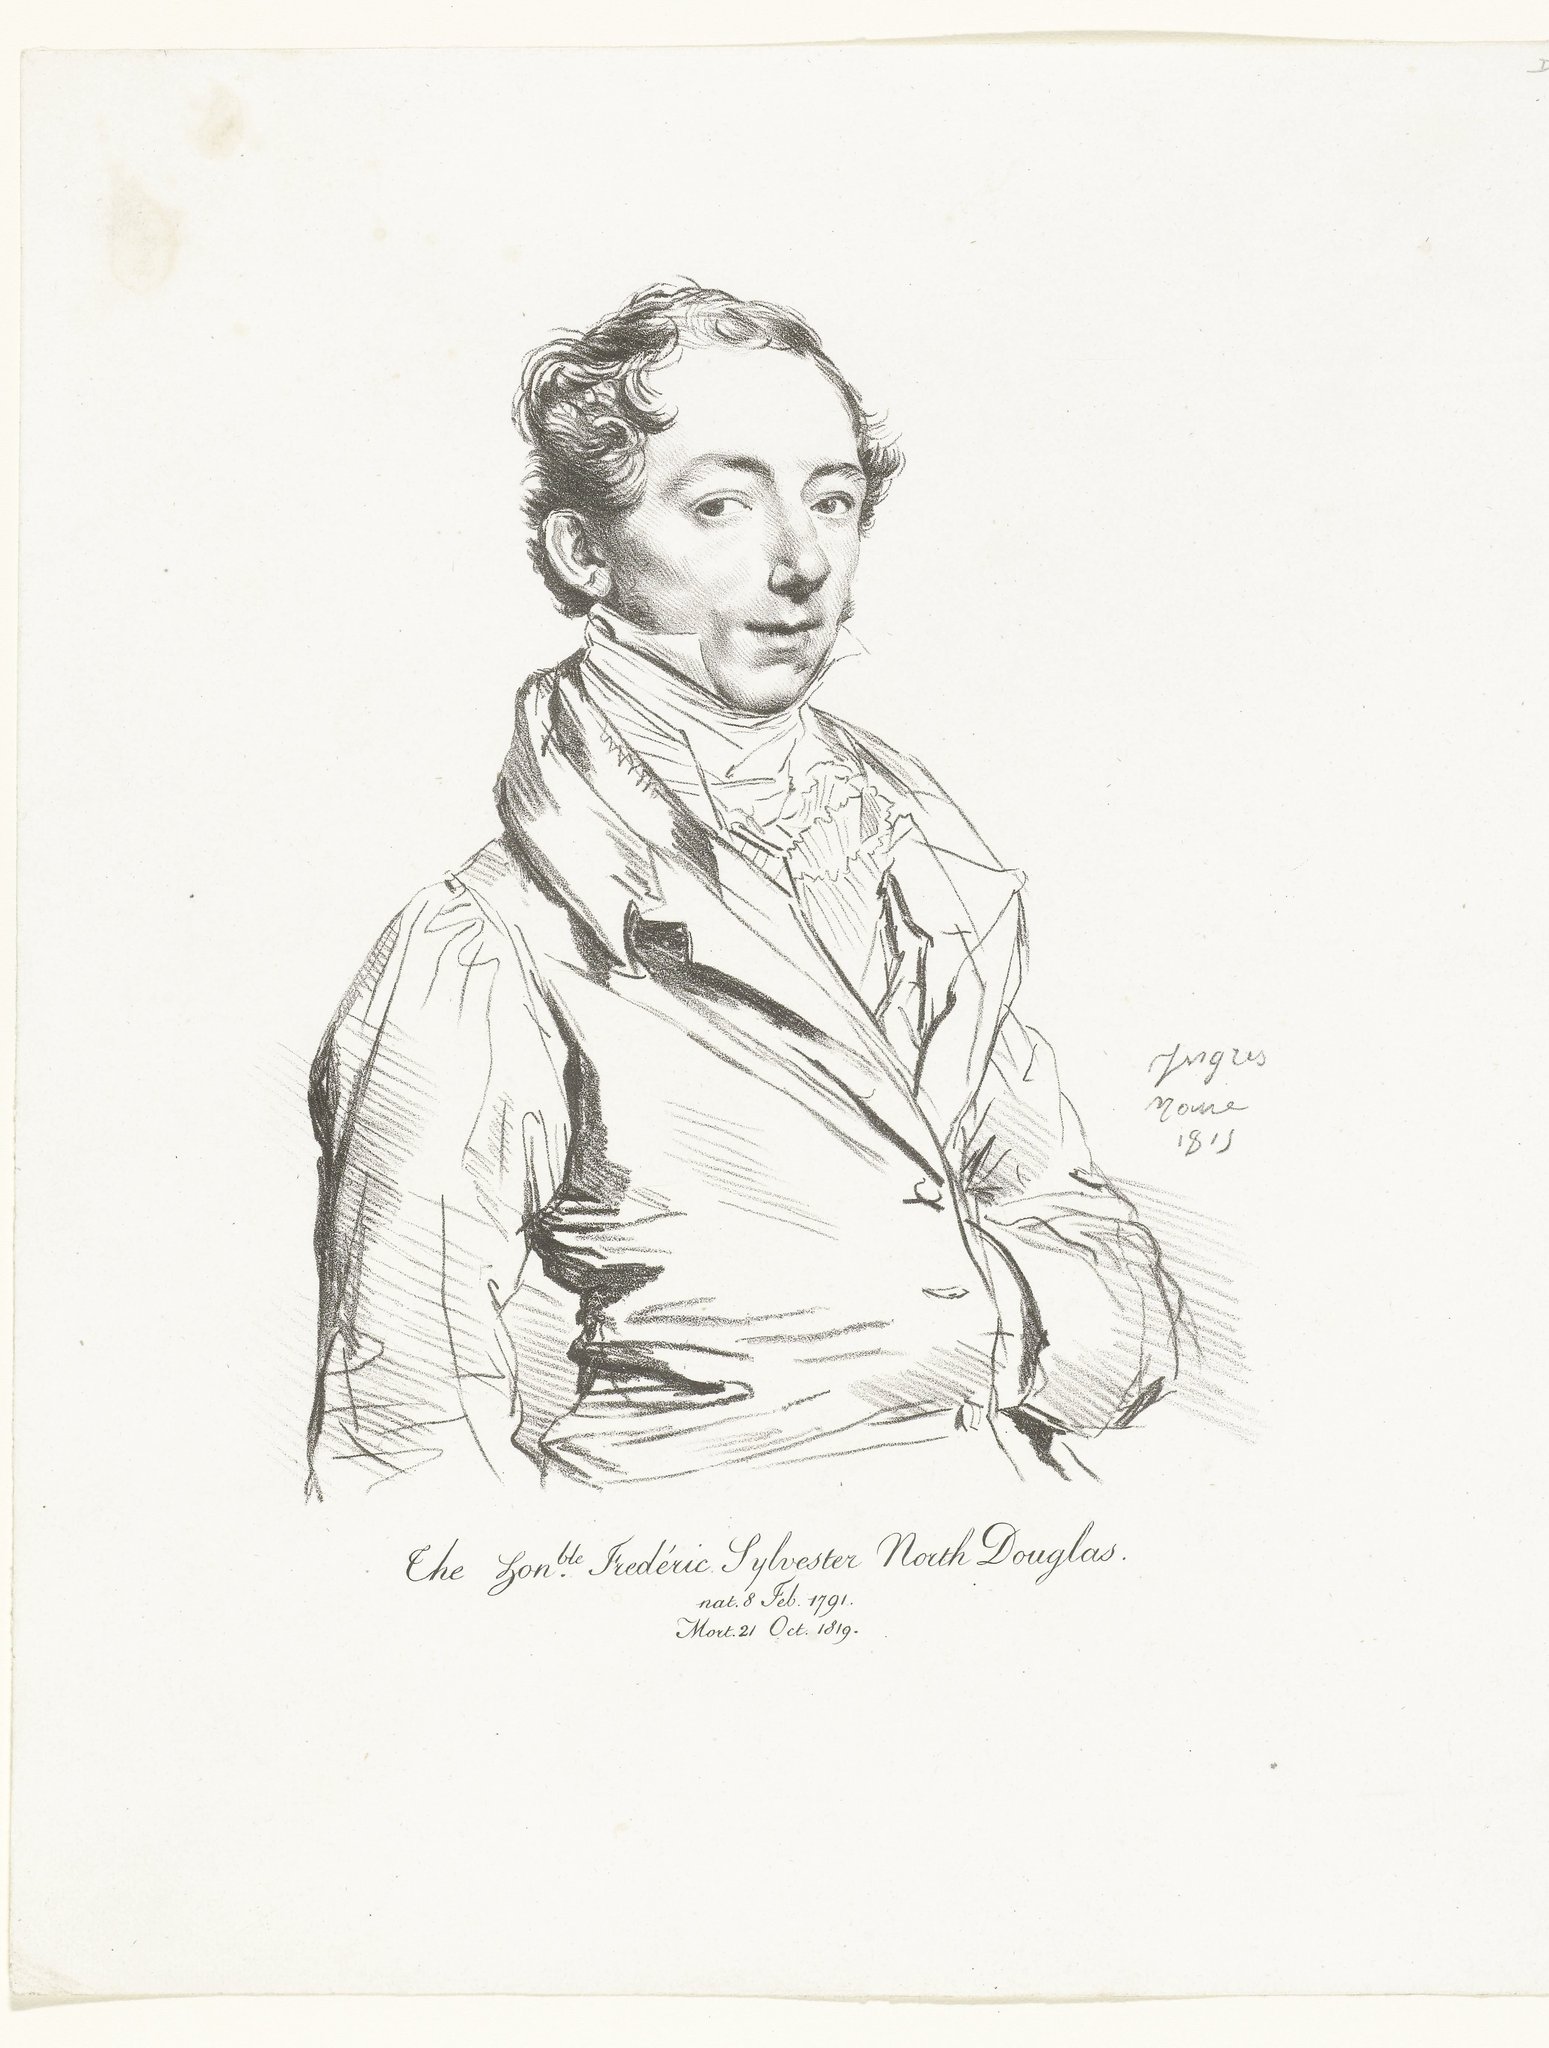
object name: print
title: Portret van Frédéric Sylvester North Douglas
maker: jean auguste dominique ingres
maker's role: draughtsman, print maker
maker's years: 1780-1867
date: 1815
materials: paper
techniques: lithograph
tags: frederic sylvester douglas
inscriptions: collector's mark: Lugt 2228, collector's mark: Lugt 2760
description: Portret van Frédéric Sylvester North Douglas in halffiguur staand met een hand gestoken in zijn jas. Onder het portret staat de naam van de man.